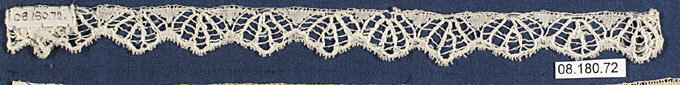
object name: fragment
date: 1801-1900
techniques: lace